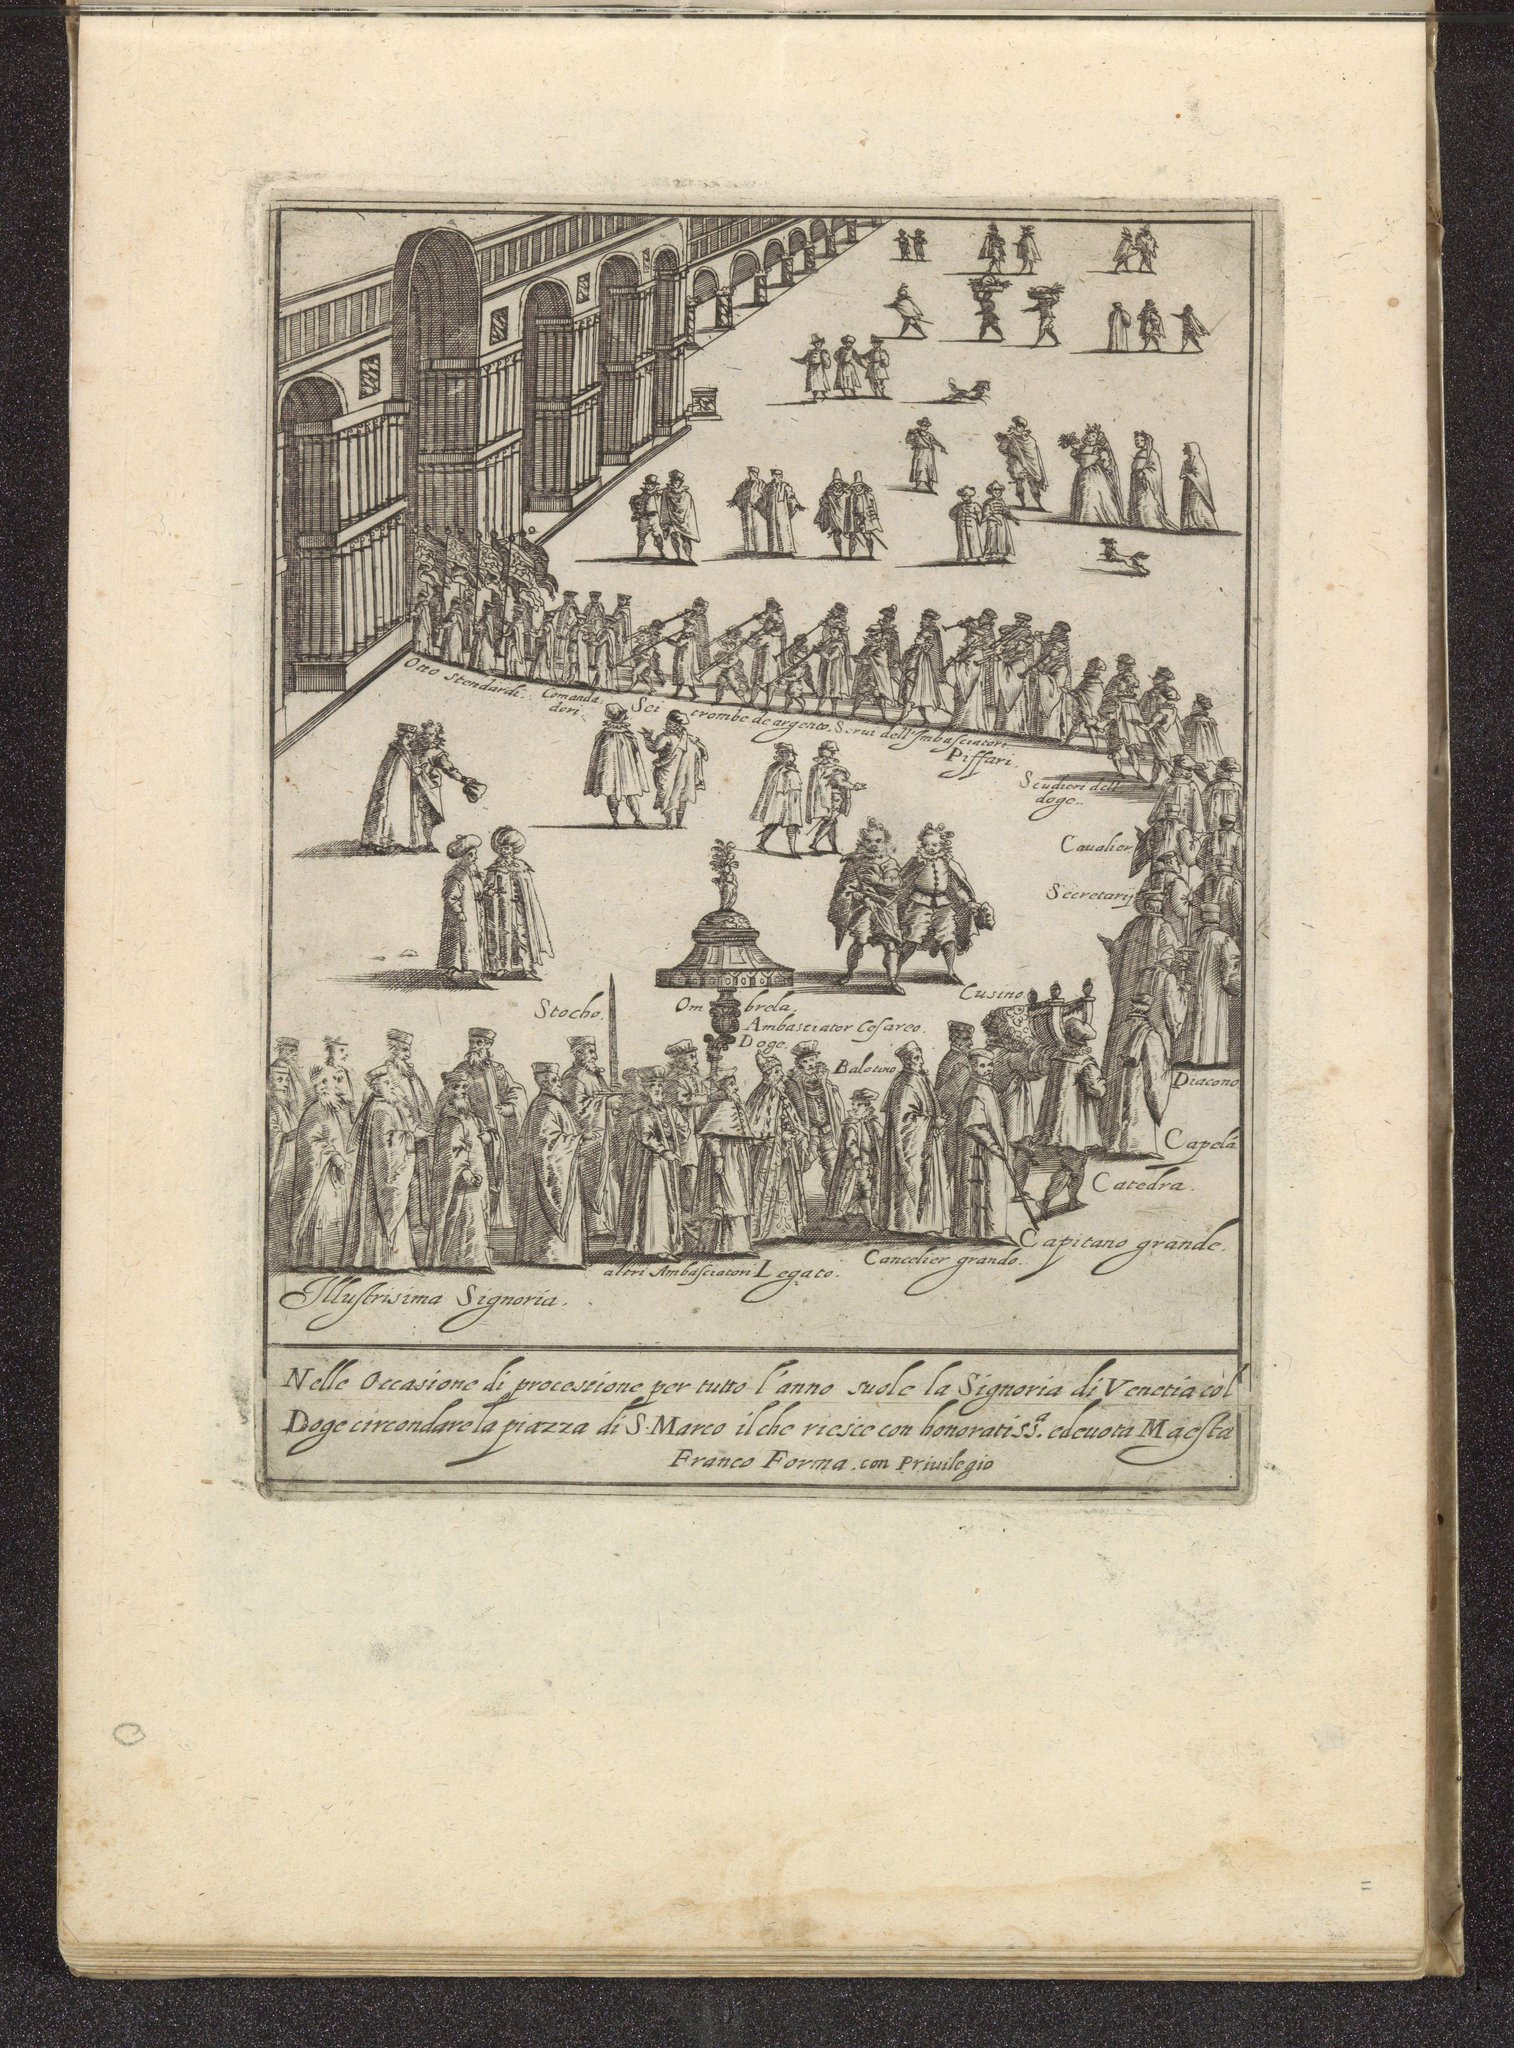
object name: album leaf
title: Habiti d'Huomeni e Donne Venetiane Con la Processione della Ser.ma Signoria Et altri particolari cioè Trionfi feste et cerimonie publiche della nobilissima città di Venetia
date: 1610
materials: paper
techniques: engraving, intaglio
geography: italy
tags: other sovereign: doge, venice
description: Optocht over het San Marcoplein naar de San Marco met de doge en de Serenissima Signoria, het bestuur van Venetië. Tweeregelige Italiaanse tekst in ondermarge. De prent maakt deel uit van een album.